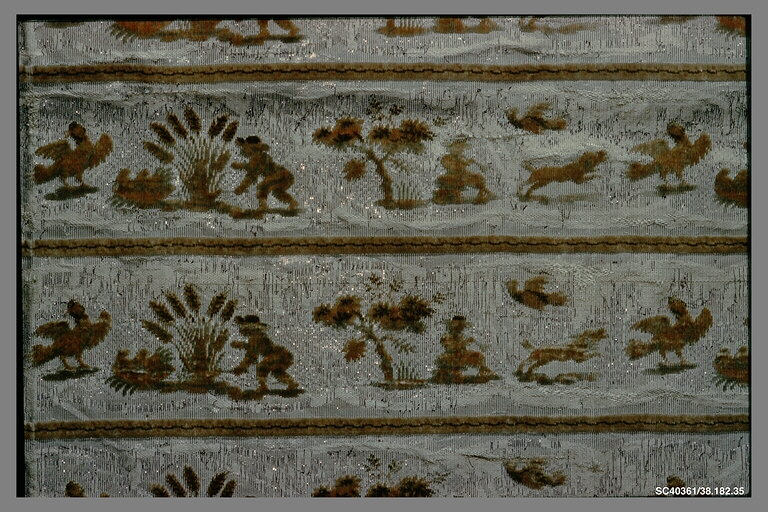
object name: piece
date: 1750-1800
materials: metal thread, silk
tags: human figures,animals,birds,trees